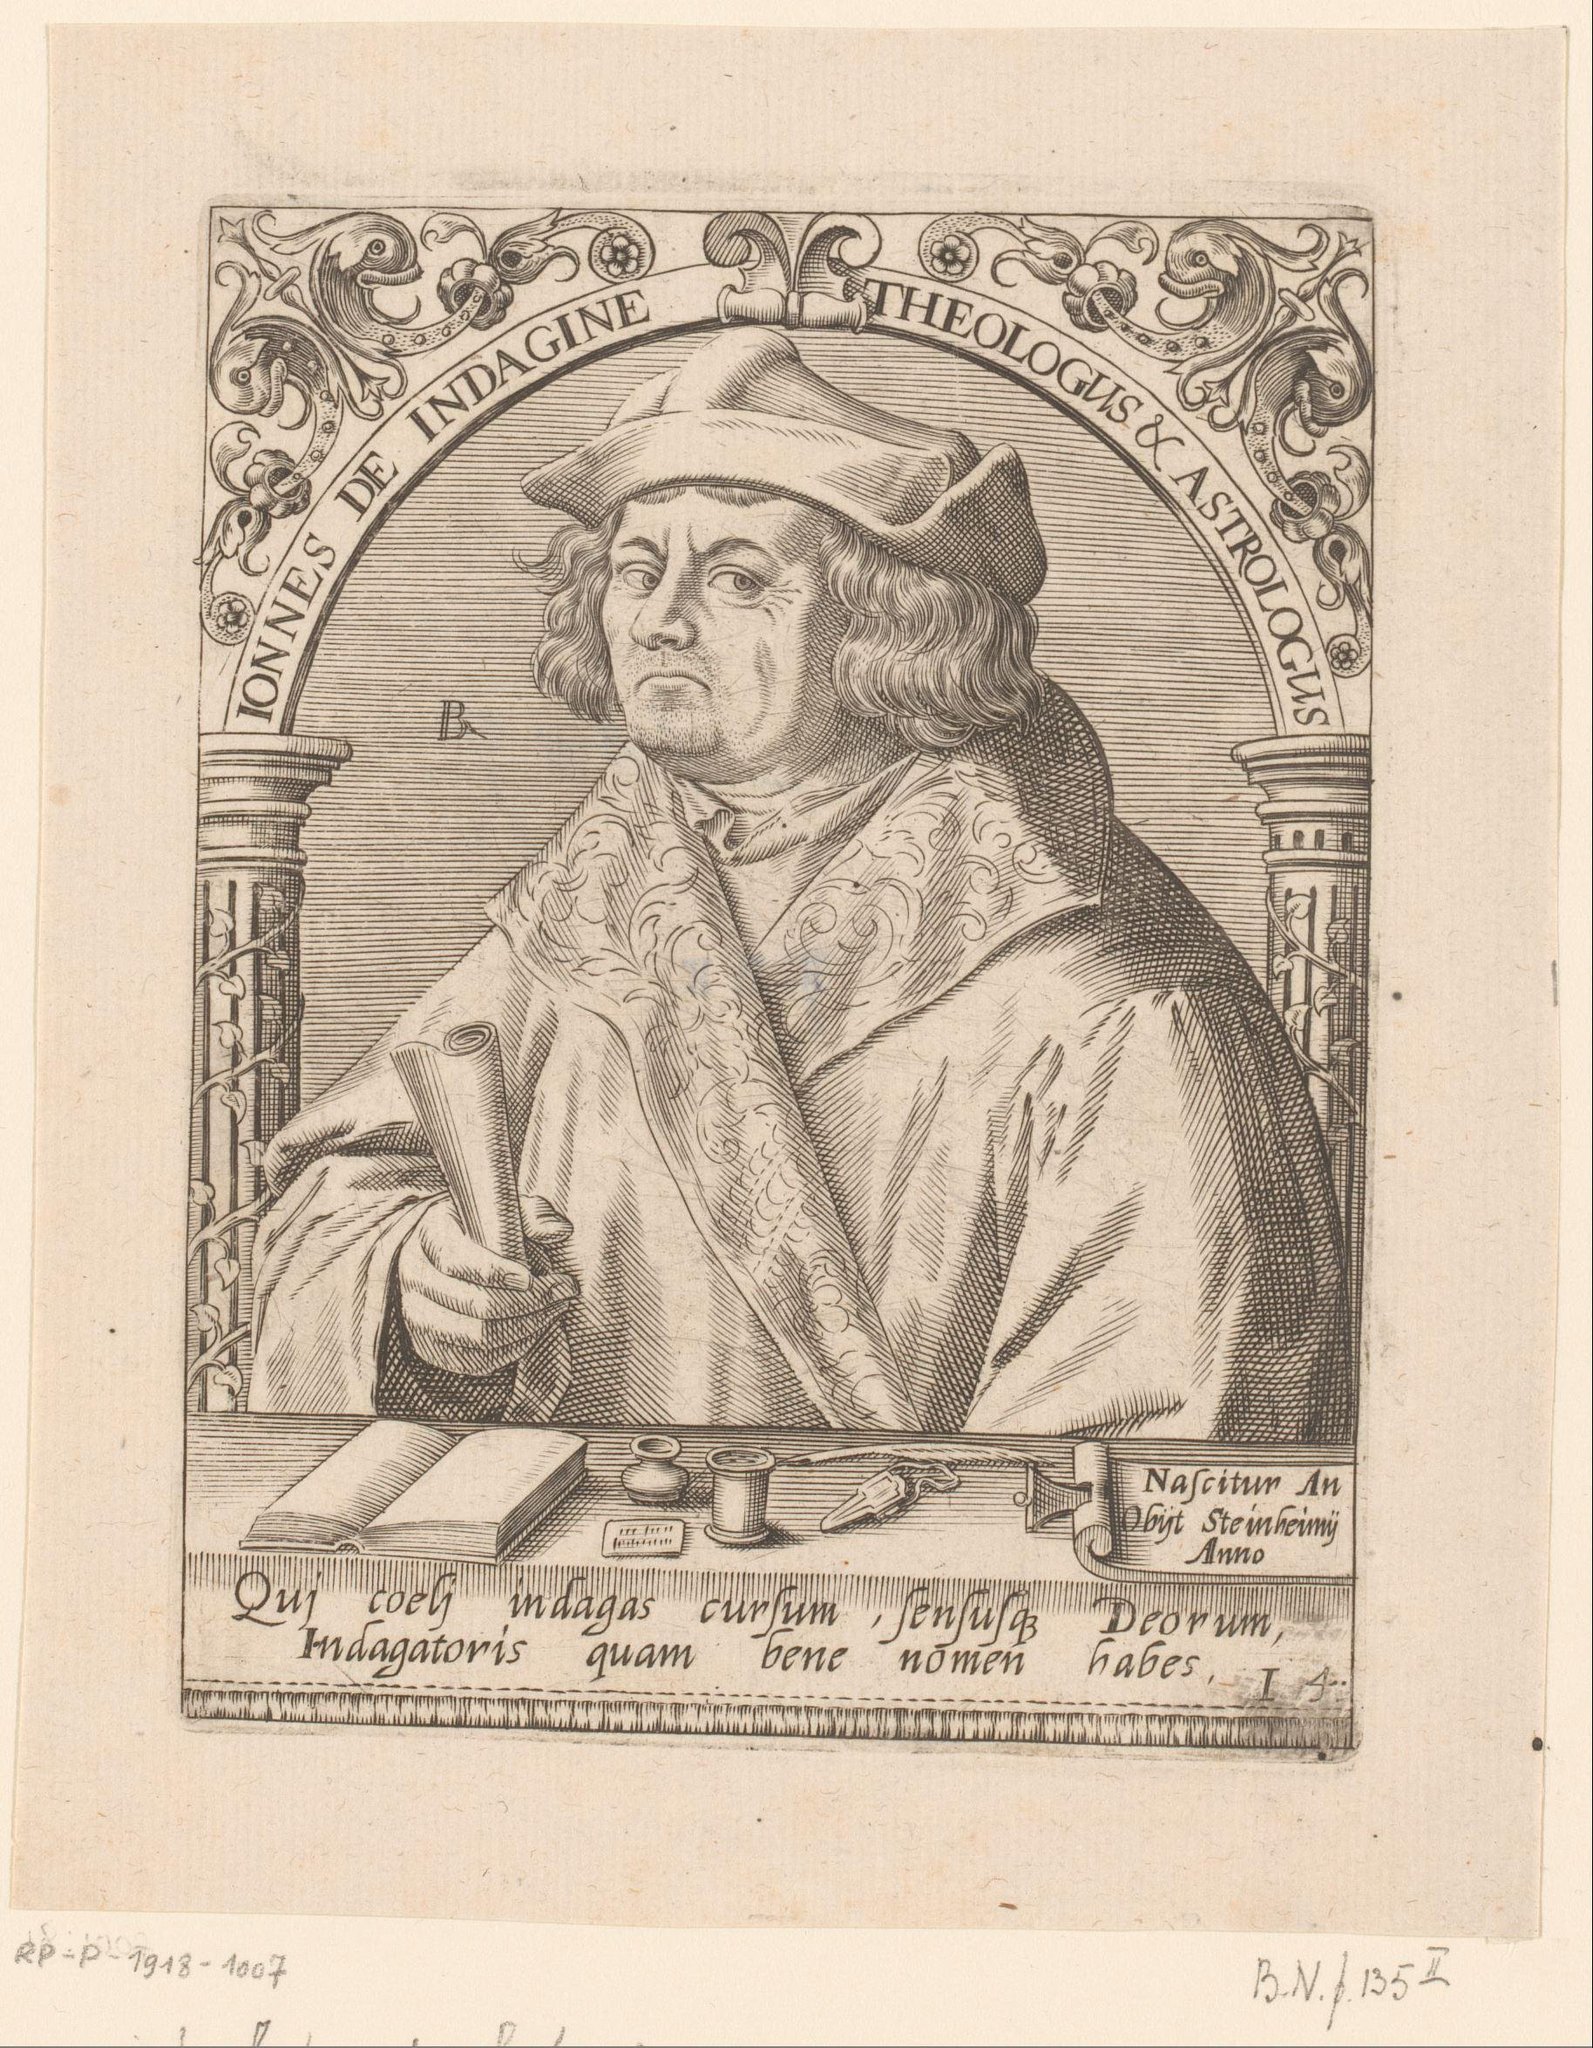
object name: print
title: Portret van Johannes Indagine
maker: robert boissard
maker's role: print maker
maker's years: 1570-1611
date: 1597-1599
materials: paper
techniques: engraving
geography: france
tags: dolphin ~ ornament - aa - stylized, ink-well, historical persons, book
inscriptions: collector's mark: Lugt 2233